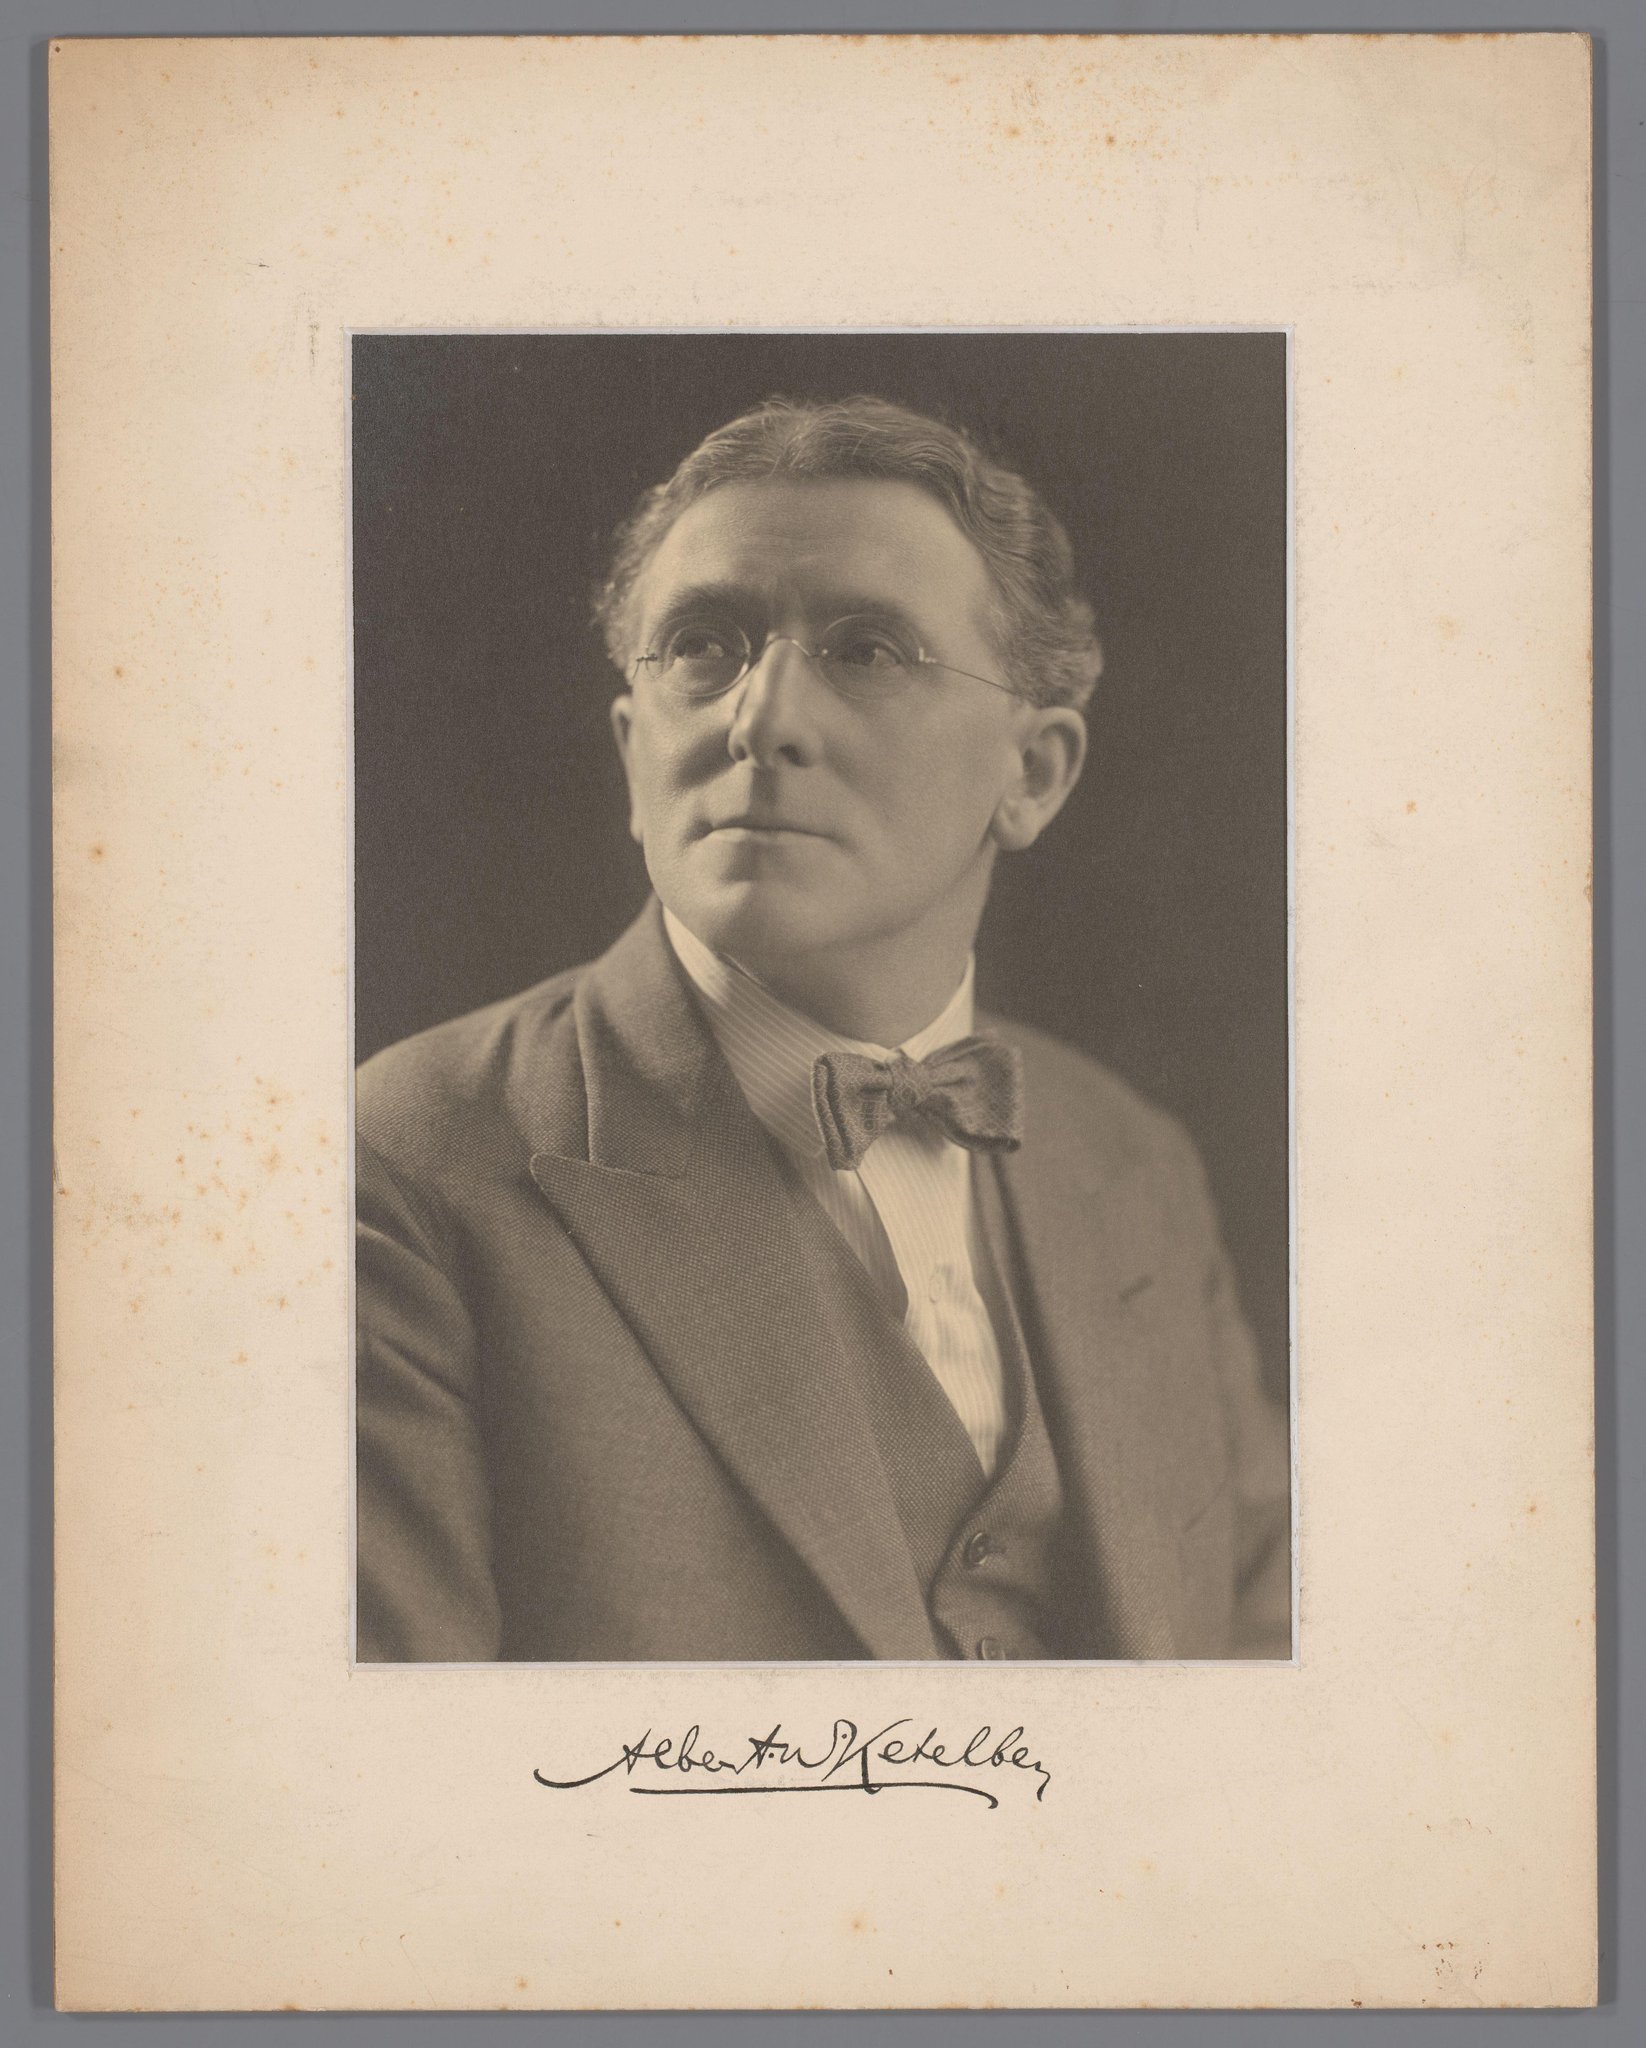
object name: photograph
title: Portret van de Hongaarse componist Albert Ketèlbey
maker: Anonymous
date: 1920-1930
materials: paper, cardboard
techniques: gelatin silver print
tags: birmingham, cowes, portrait of a musician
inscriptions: inscription: ‘Albert Ketelbey’, inscription: ‘foto afkomstig legaat van de fam [...] A'dam 1961/ COMPONIST’